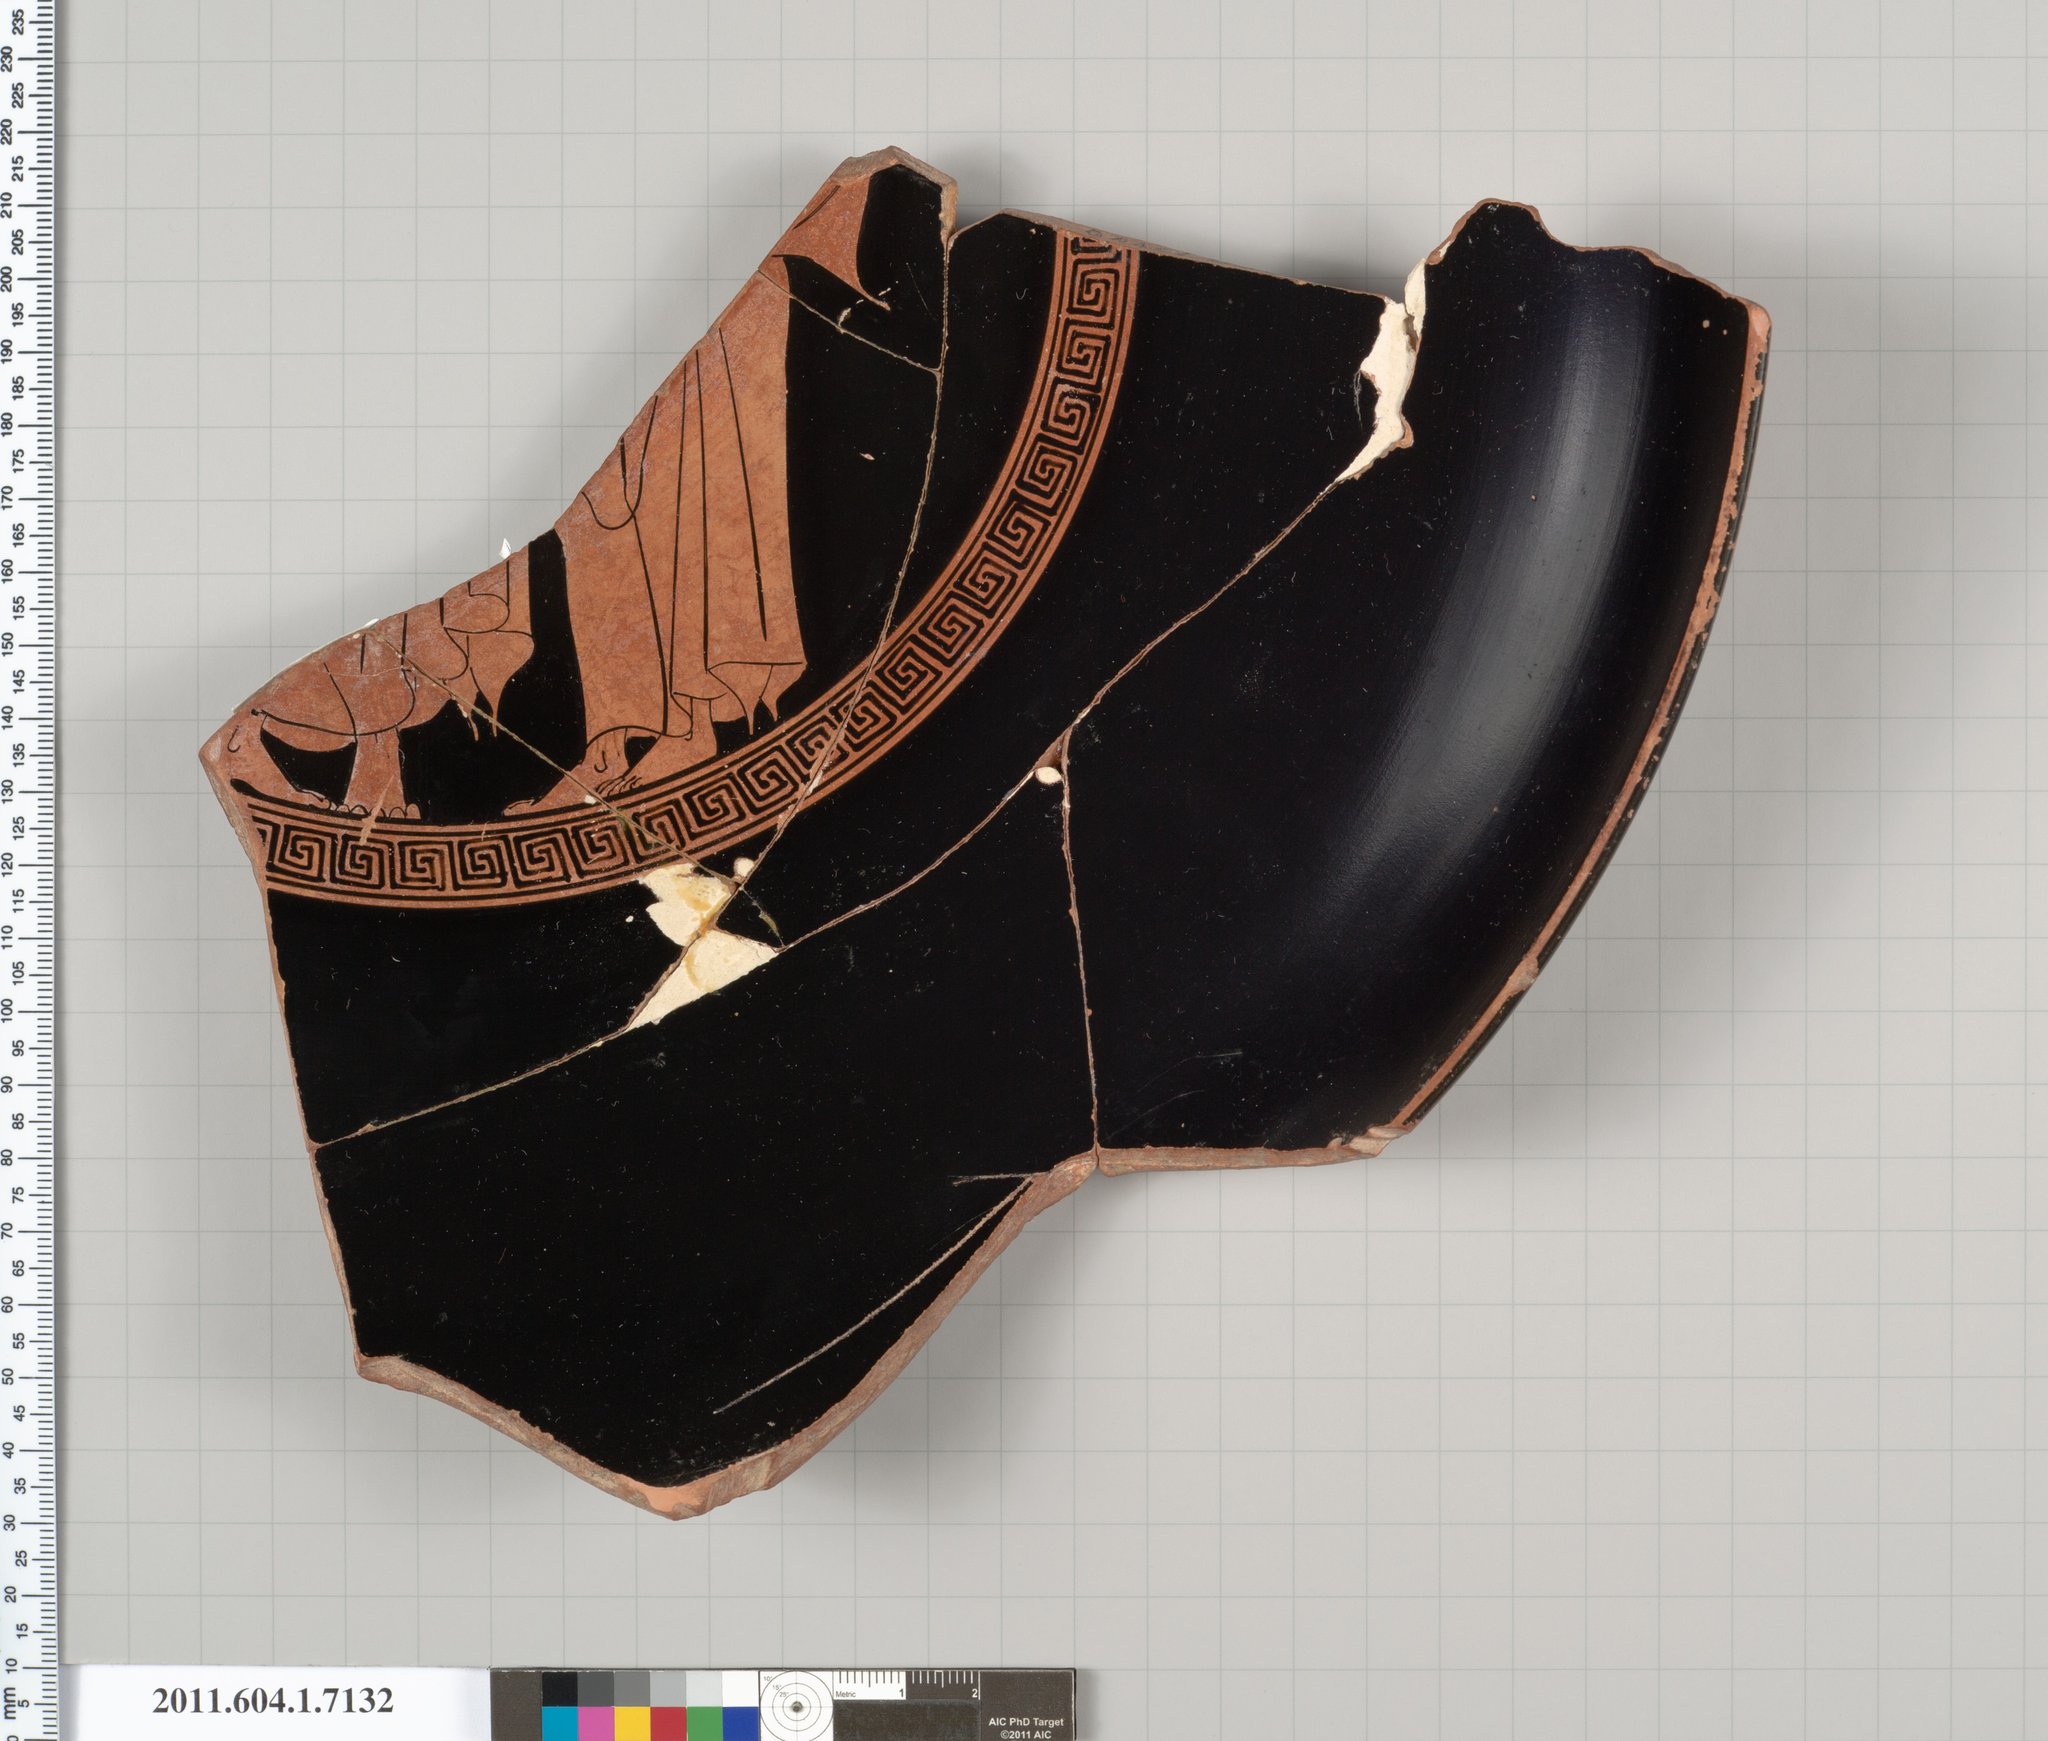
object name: kylix fragment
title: Terracotta fragment of a kylix (drinking cup)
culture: greek, attic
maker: makron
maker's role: artist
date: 500-480 BCE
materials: terracotta